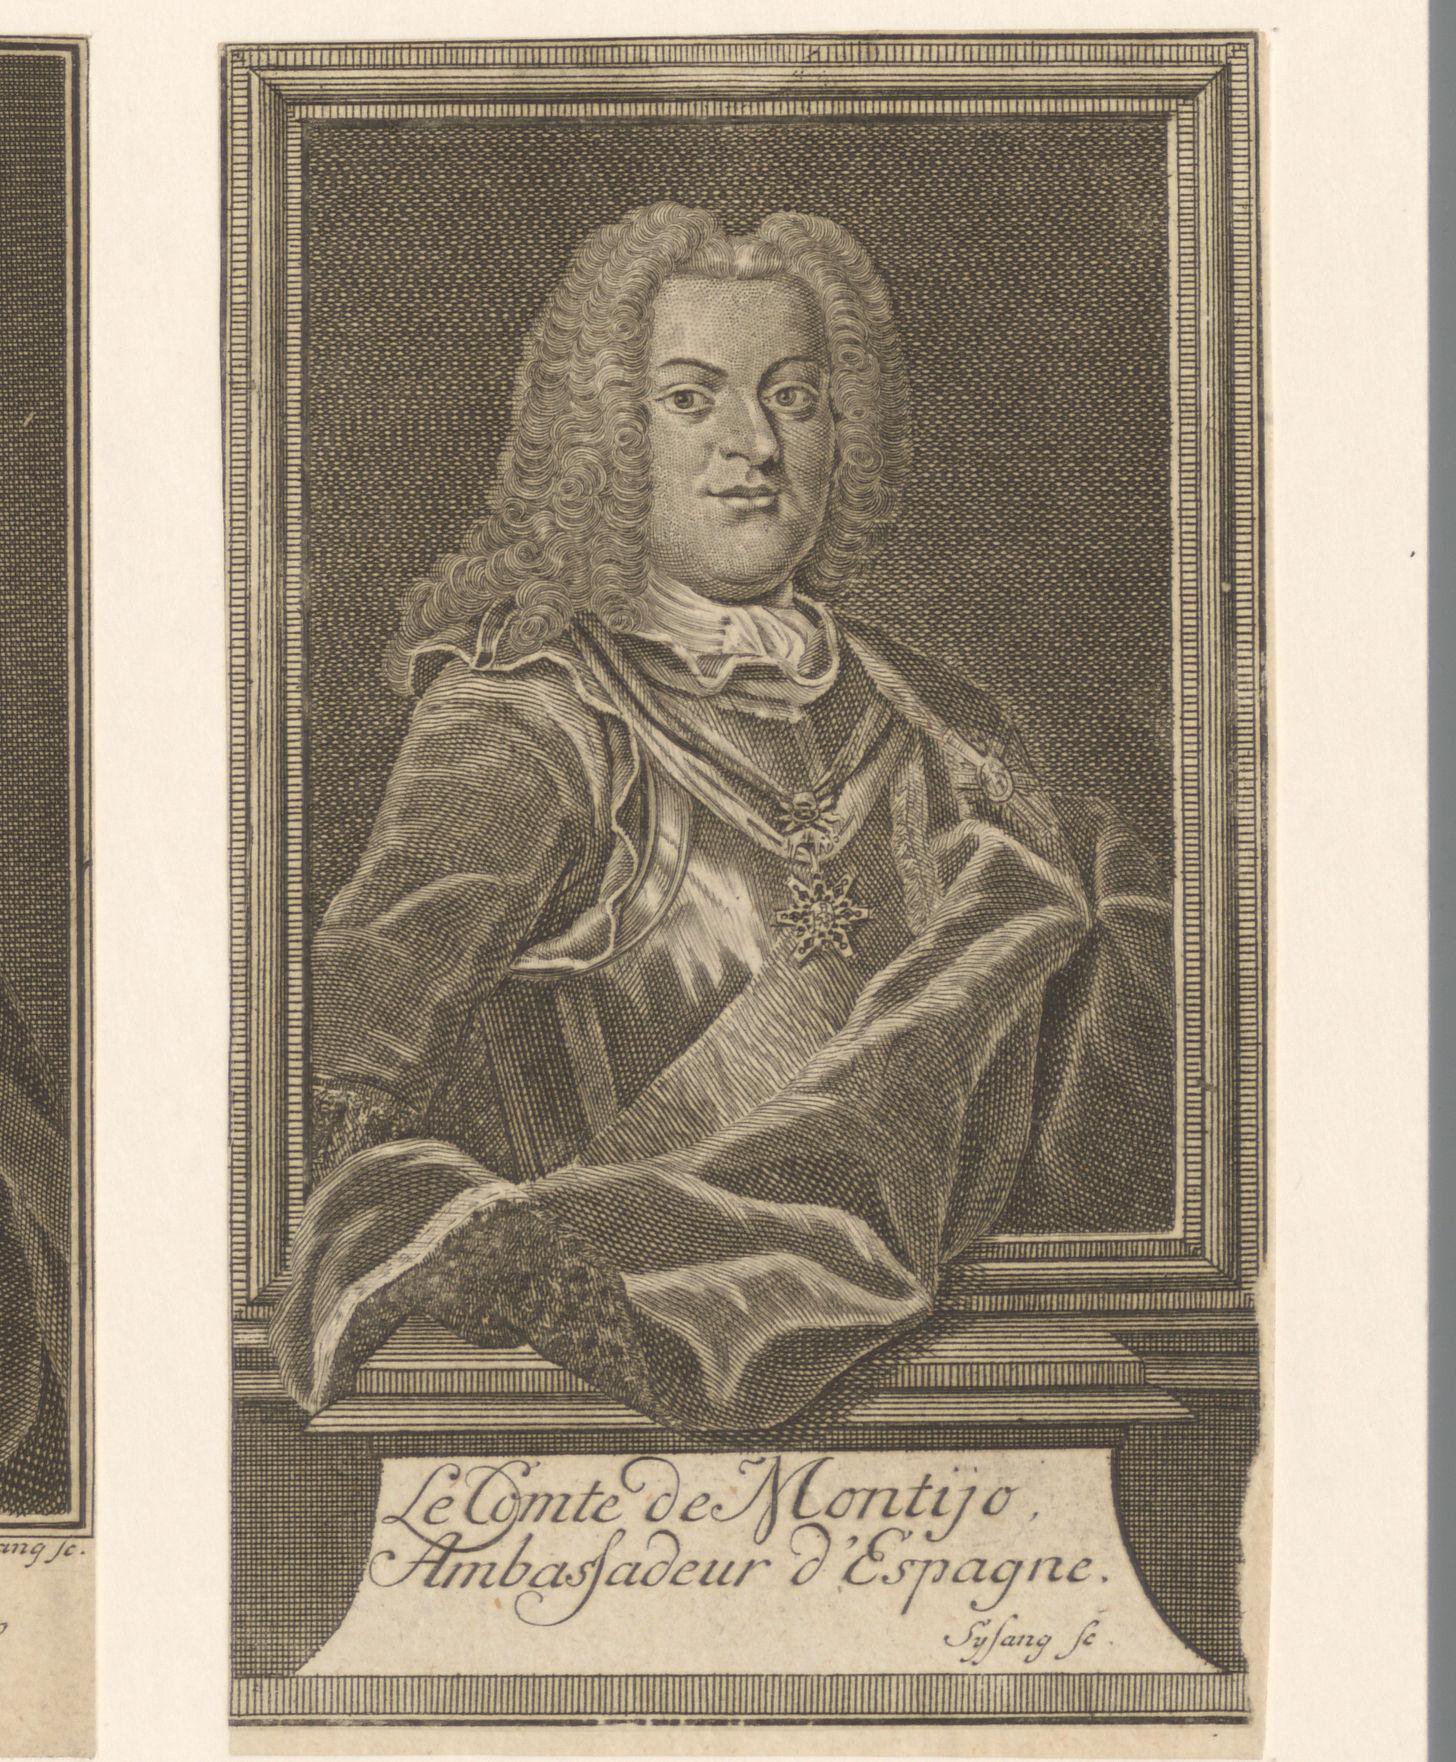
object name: print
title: Portret van Cristóbal Gregorio Portocarrero, conde de Montijo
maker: johann christoph sysang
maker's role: print maker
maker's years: 1703-1757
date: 1741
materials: paper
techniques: engraving, etching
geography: leipzig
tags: historical persons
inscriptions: collector's mark: Lugt 2228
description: Prent gebruikt voor de publicatie: Europäischer Staats-Secretarius. Leipzig: Moritz Georg II Weidmann, 1741, dl. 70.